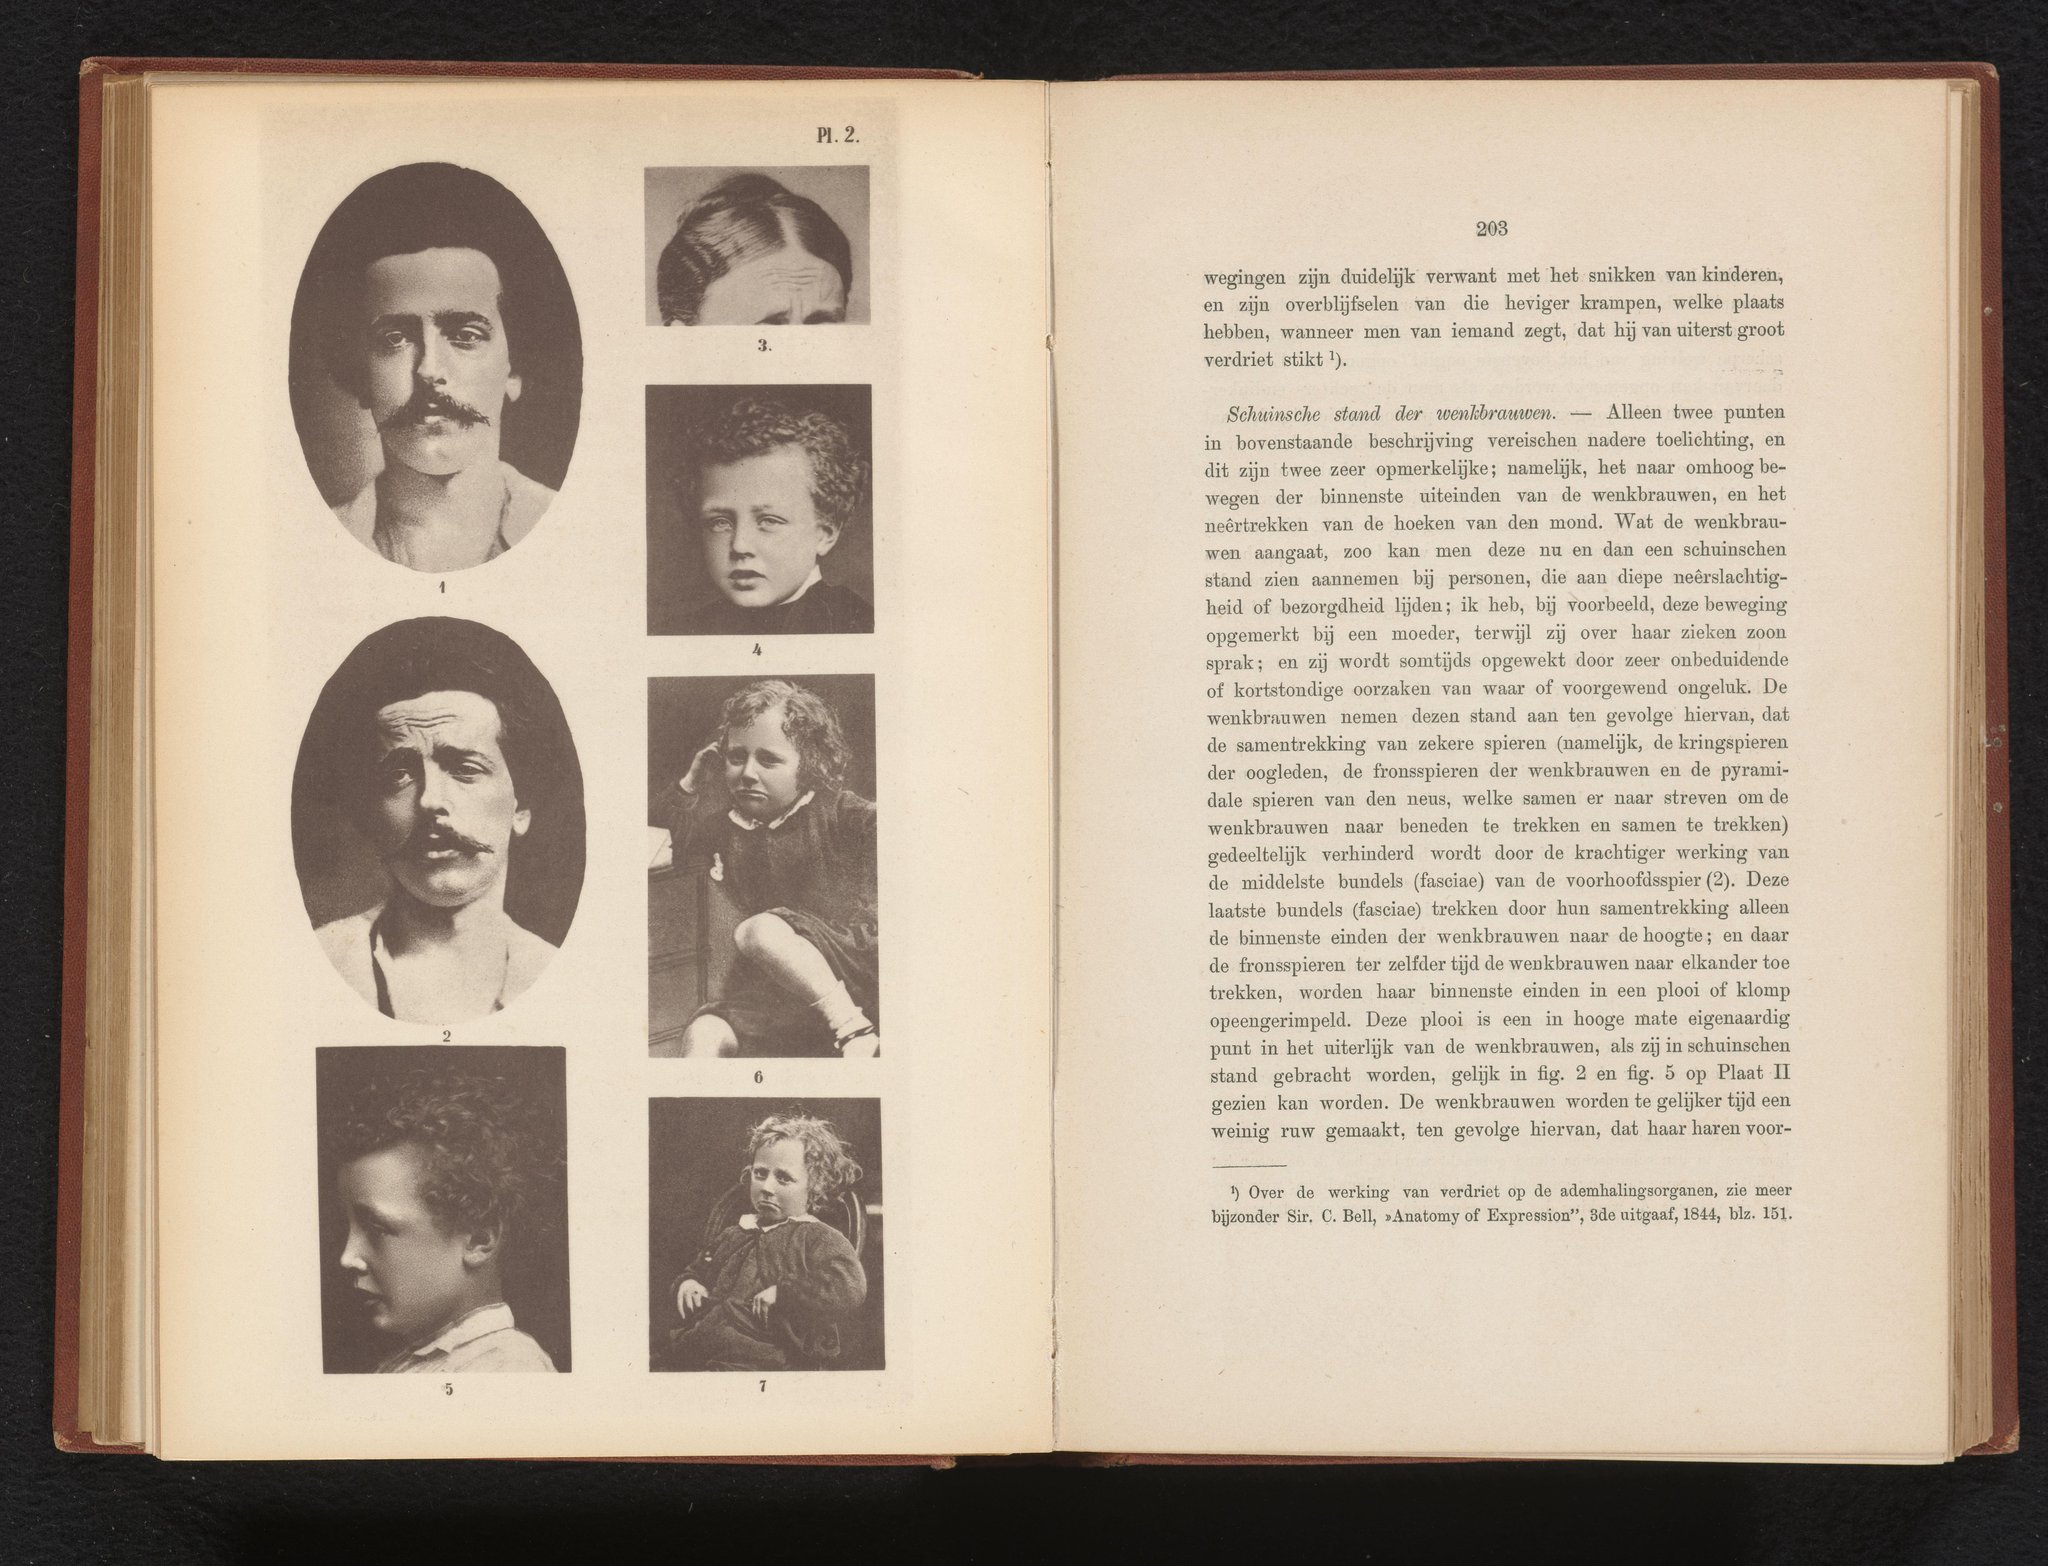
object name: page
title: Overzicht van zeven foto's ter illustratie van mensen met verschillende gezichtsuitdrukkingen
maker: Anonymous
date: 1868-1873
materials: paper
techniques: photograph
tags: historical persons, morphology of facial expression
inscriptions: inscription: ‘Pl. 2.’